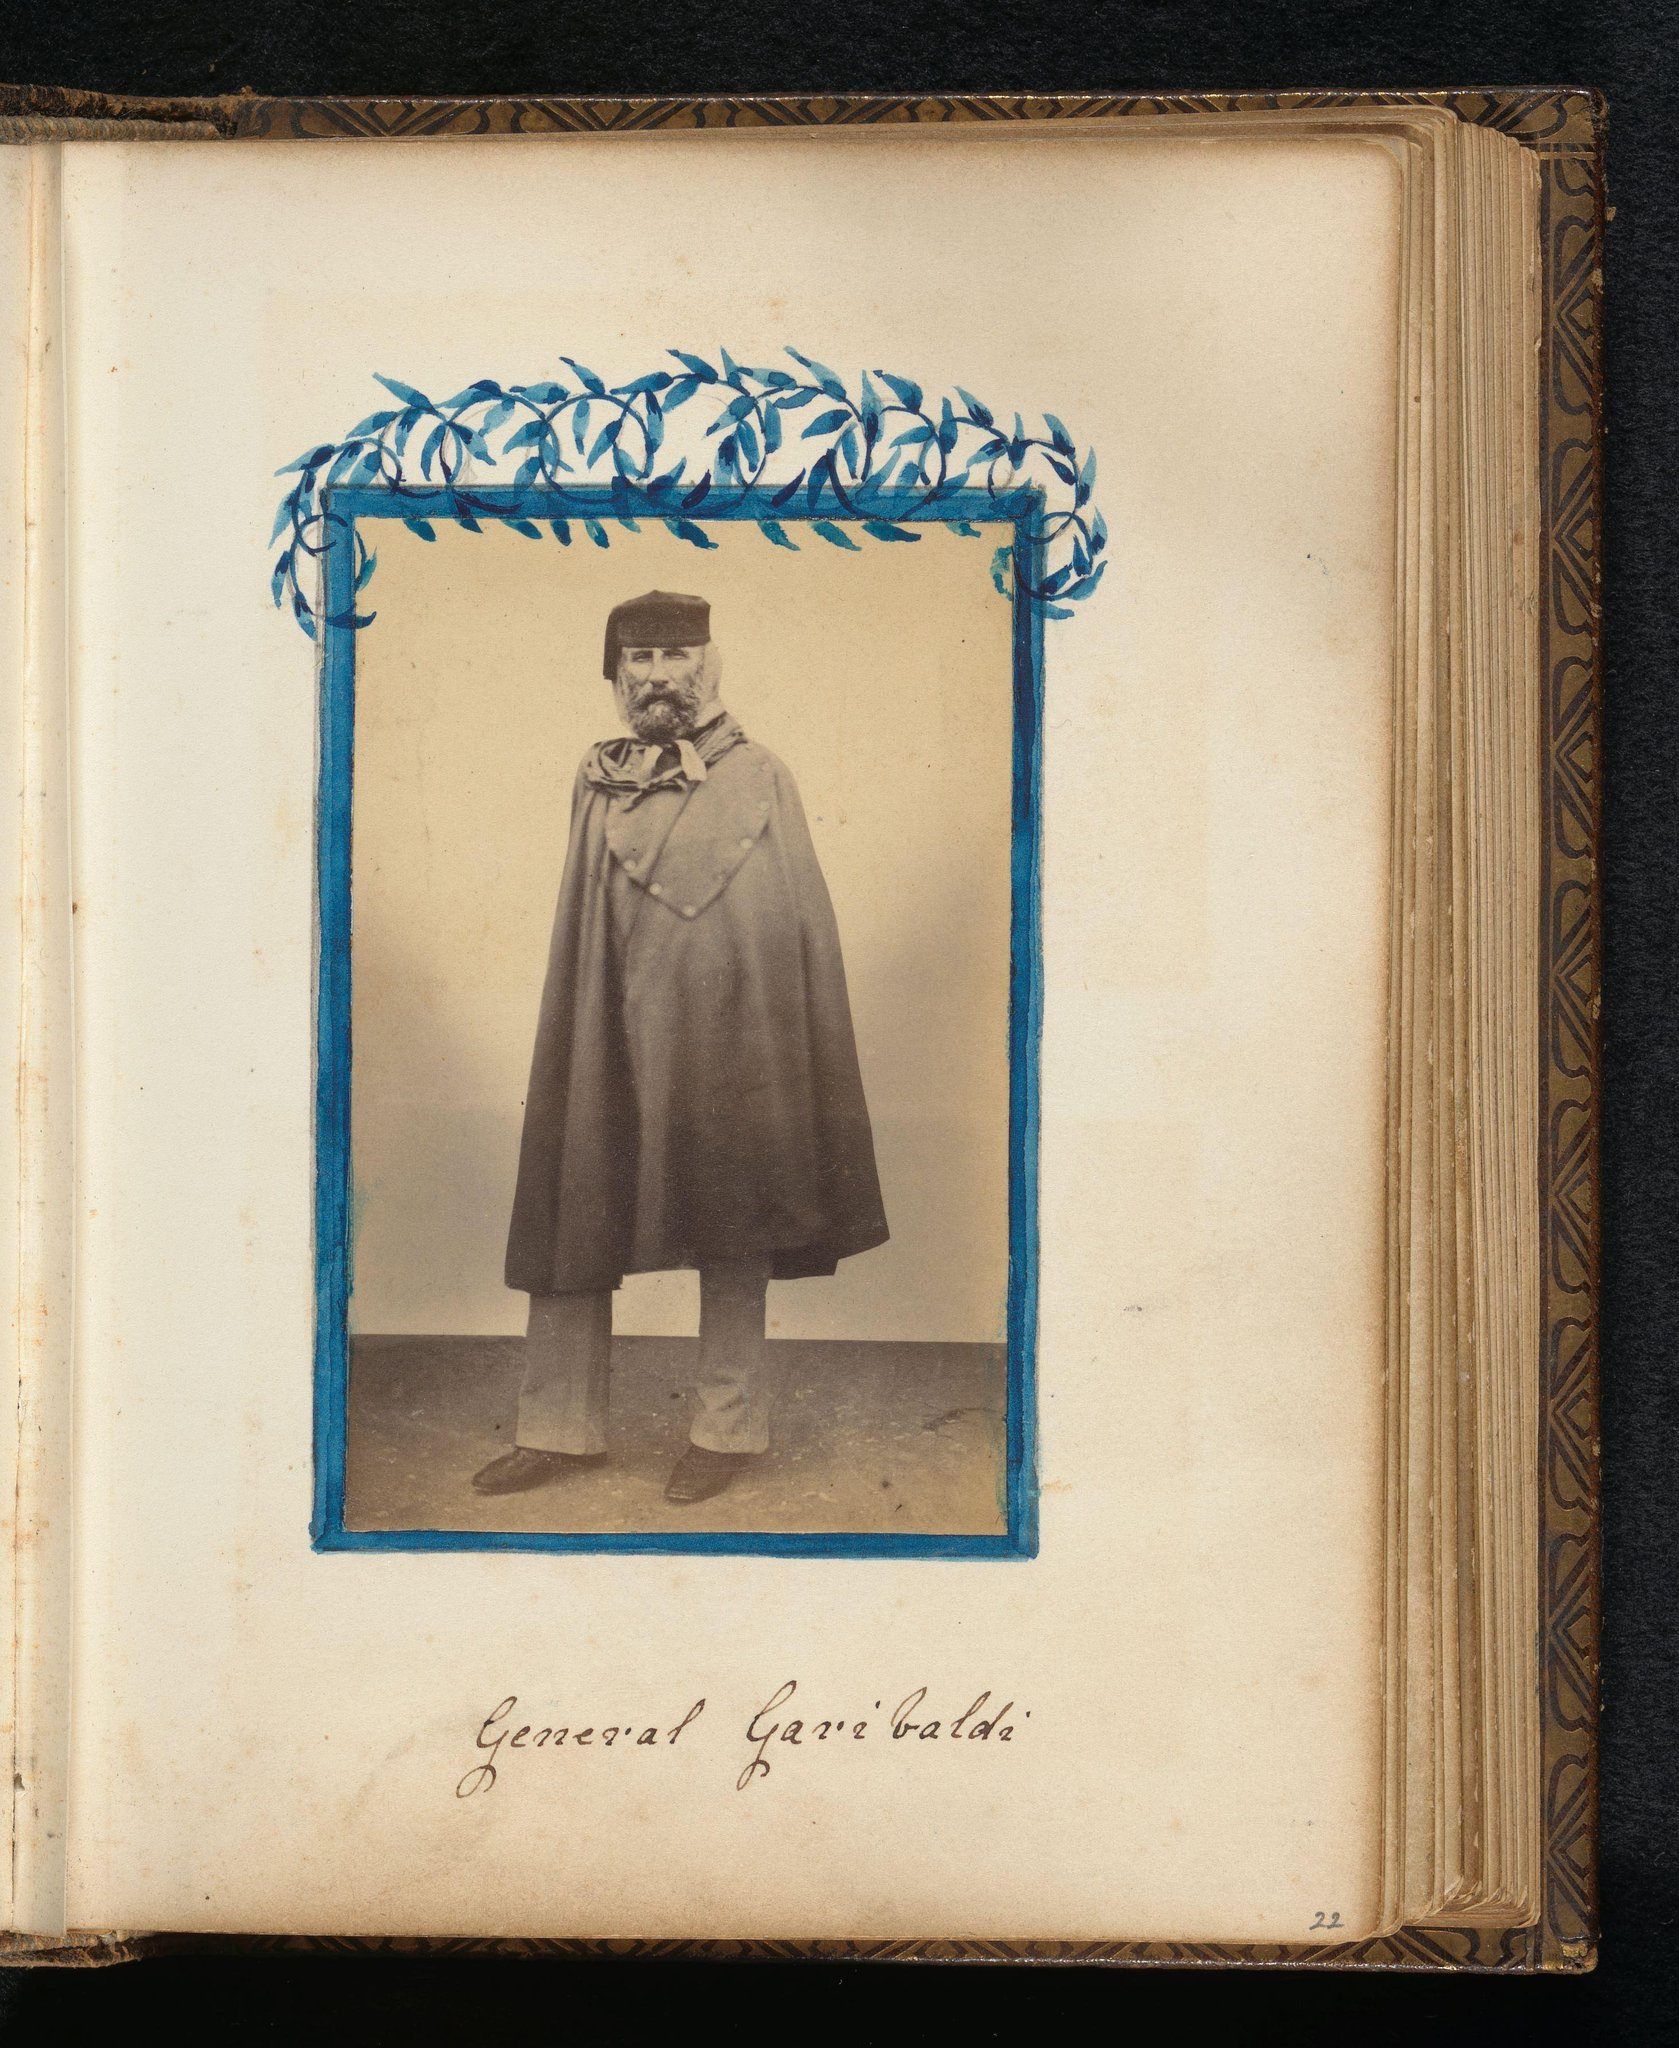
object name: photograph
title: Portret van Garibaldi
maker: Anonymous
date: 1865-1867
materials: cardboard, photographic support, watercolor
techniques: albumen print, aquarelle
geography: england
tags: commander-in-chief, general, marshal, historical persons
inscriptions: annotation: ‘General Garibaldi’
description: Portret van de Italiaanse generaal Giuseppe Garibaldi. Foto op albumblad in album met 68 foto's merendeels met geaquarelleerde randversieringen. Het zijn voornamelijk portretten op carte-de-visite formaat.